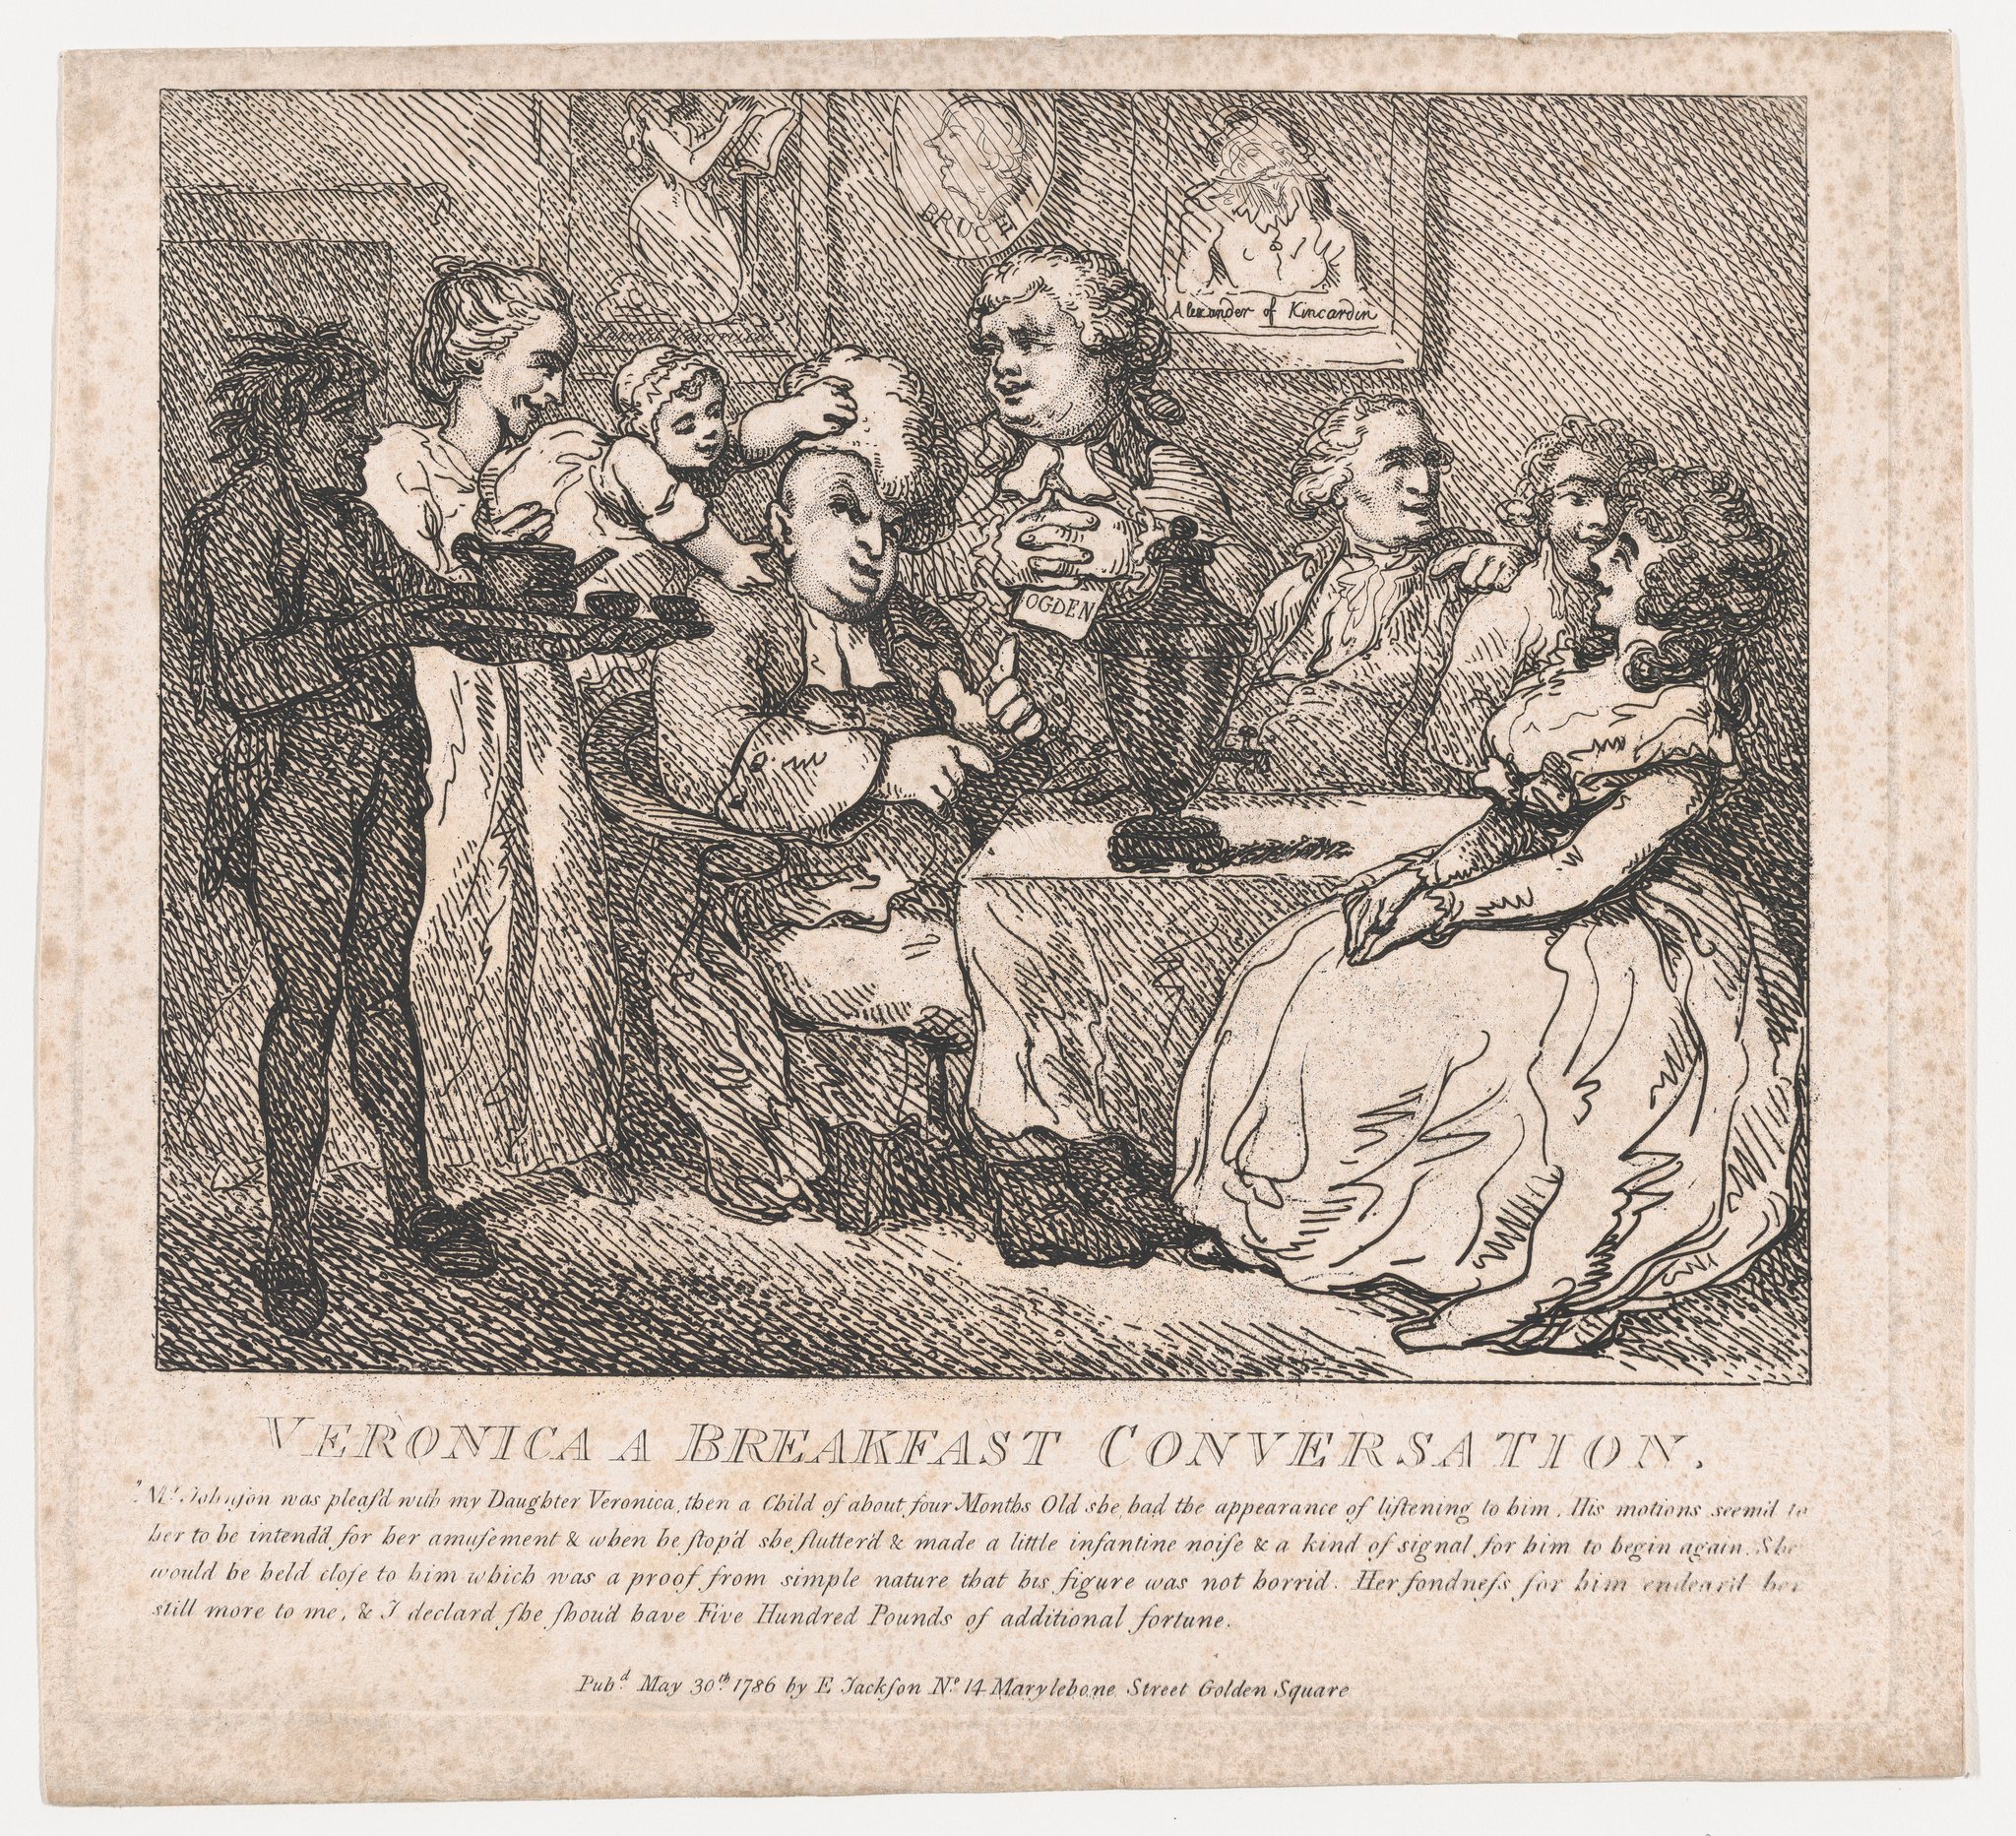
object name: print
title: Veronica, a Breakfast Conversation (Picturesque Beauties of Boswell, Part the First)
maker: thomas rowlandson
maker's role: artist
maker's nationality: british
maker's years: 1757-1827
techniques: etching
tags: men,women,dining